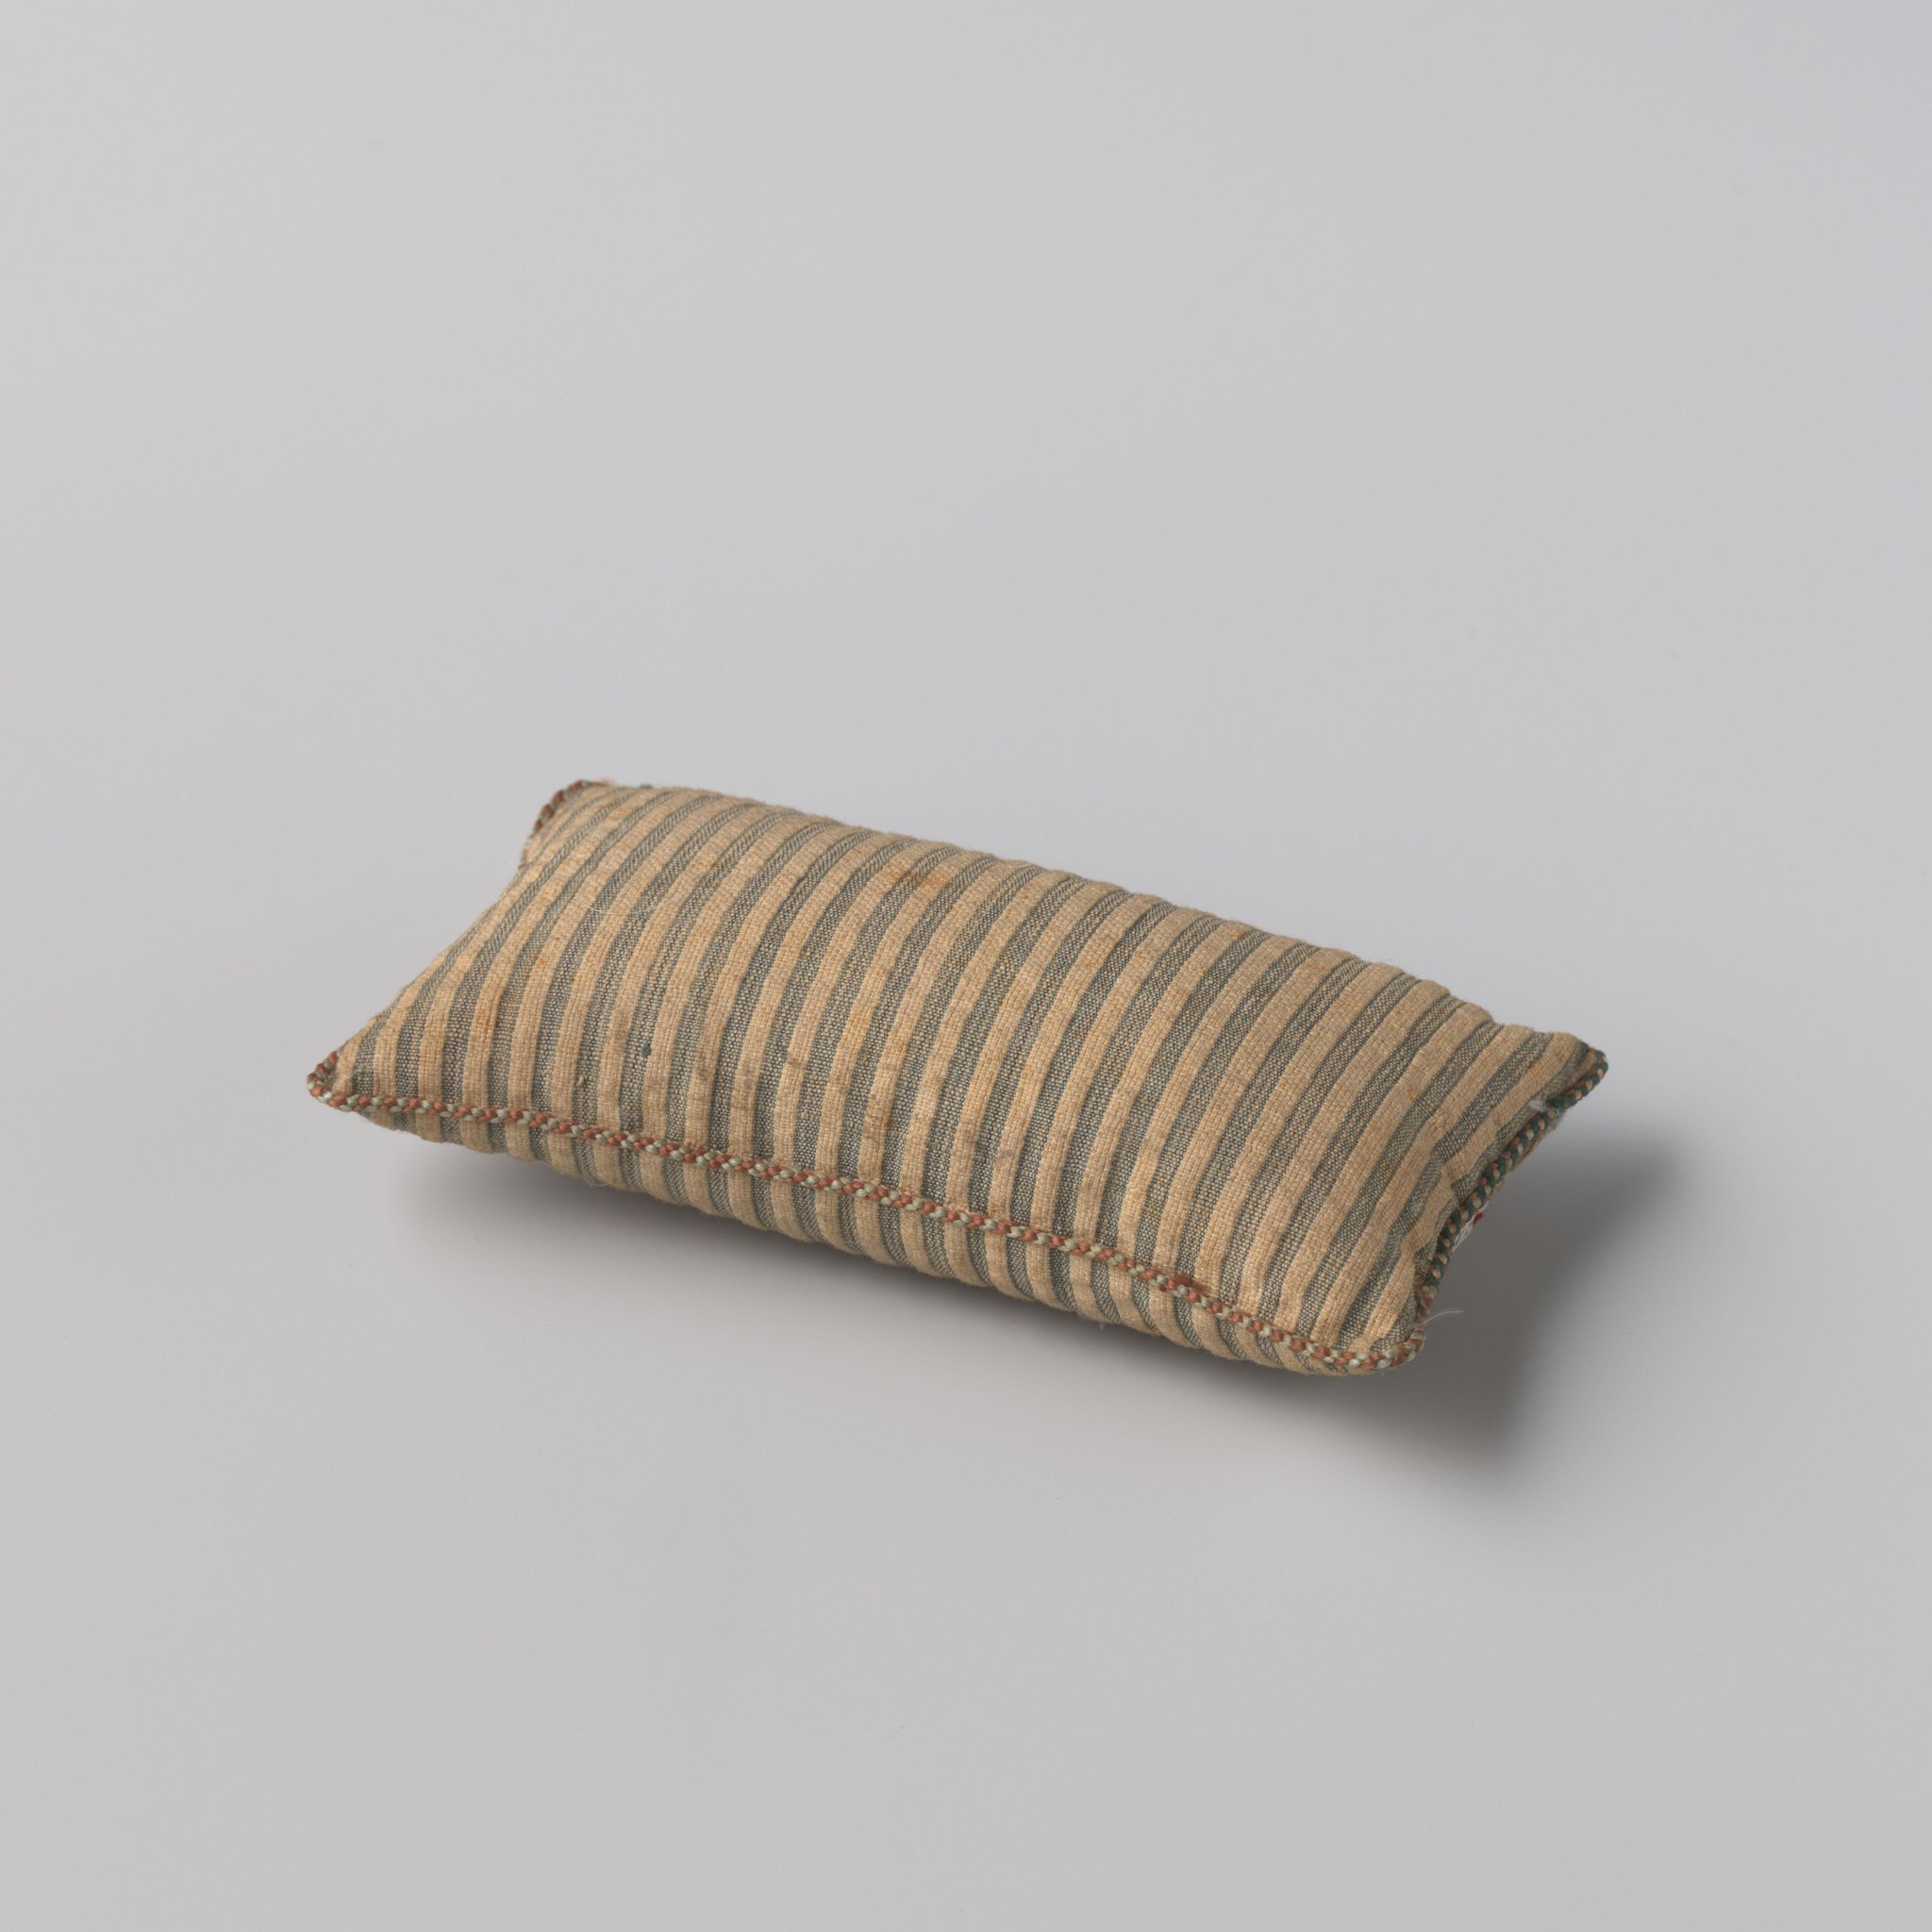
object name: miniature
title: Peluw van blauw-wit gestreept linnen- en katoenweefsel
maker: Anonymous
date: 1690-1710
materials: cotton, down, linen, silk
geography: amsterdam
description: Peluw van blauw-wit gestreept linnen- en katoenweefsel, omboord met een gevlochten koord, van lichtblauwe en bruine zijde, en (iets minder dan de helft) groene/bruin/witte zijde; gevuld met dons.